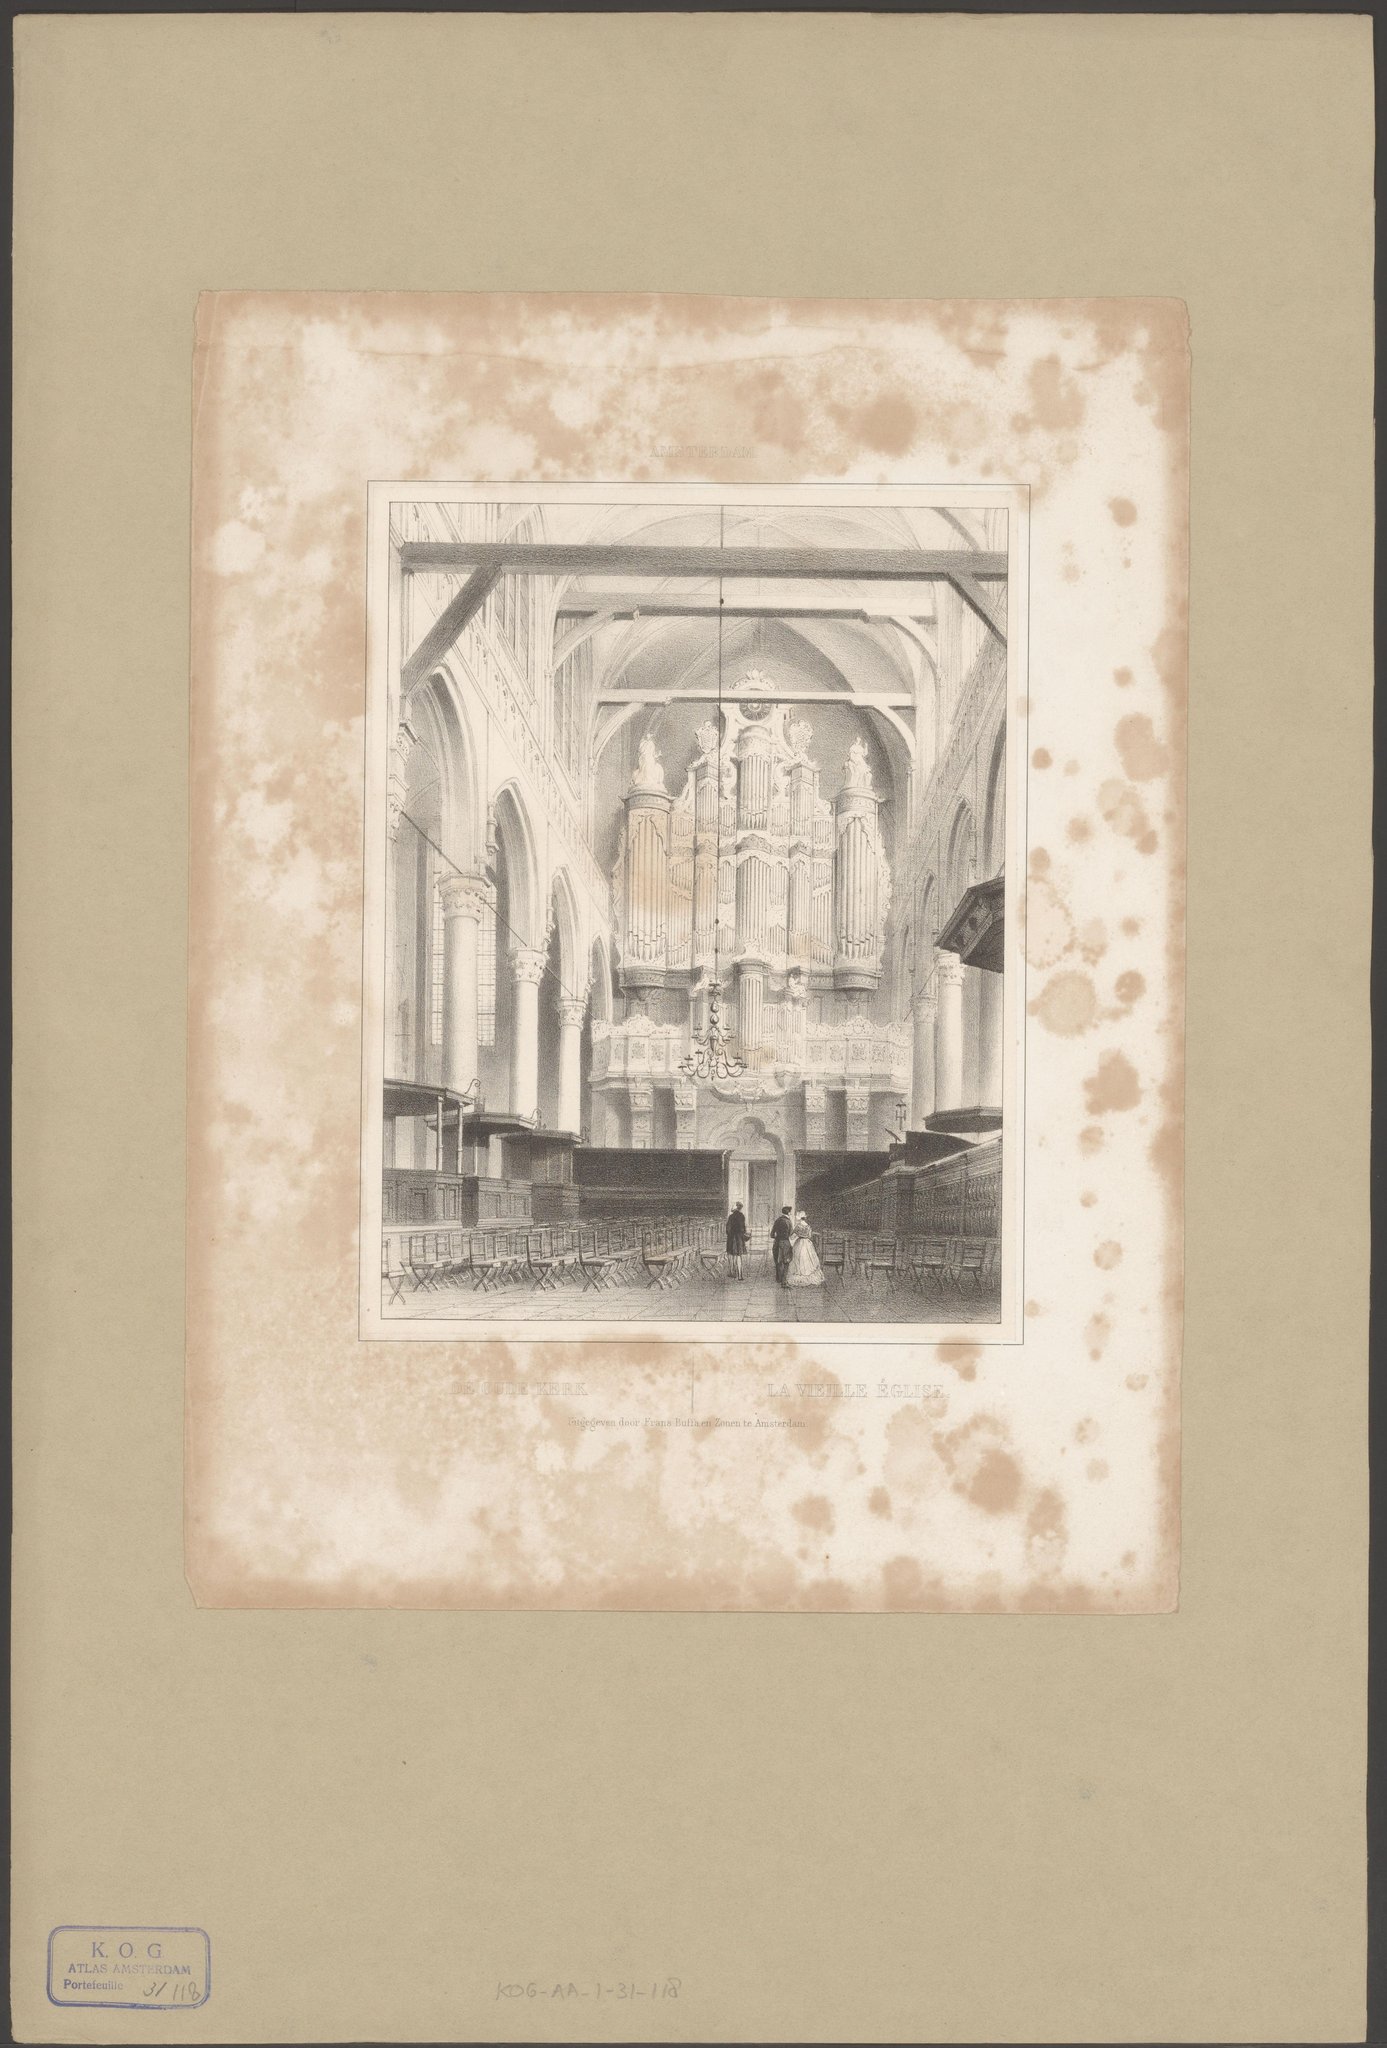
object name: print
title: Gezicht op het interieur van de Oude Kerk te Amsterdam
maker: Anonymous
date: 1836-1899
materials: paper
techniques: lithograph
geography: amsterdam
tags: church organ, interior of church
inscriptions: collector's mark: ‘31.118’ Lugt 1641b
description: Onderwerpsrubriek binnen de Atlas Amsterdam: Kerkwezen: Hervormde Gemeente: Oude Kerk van binnen.